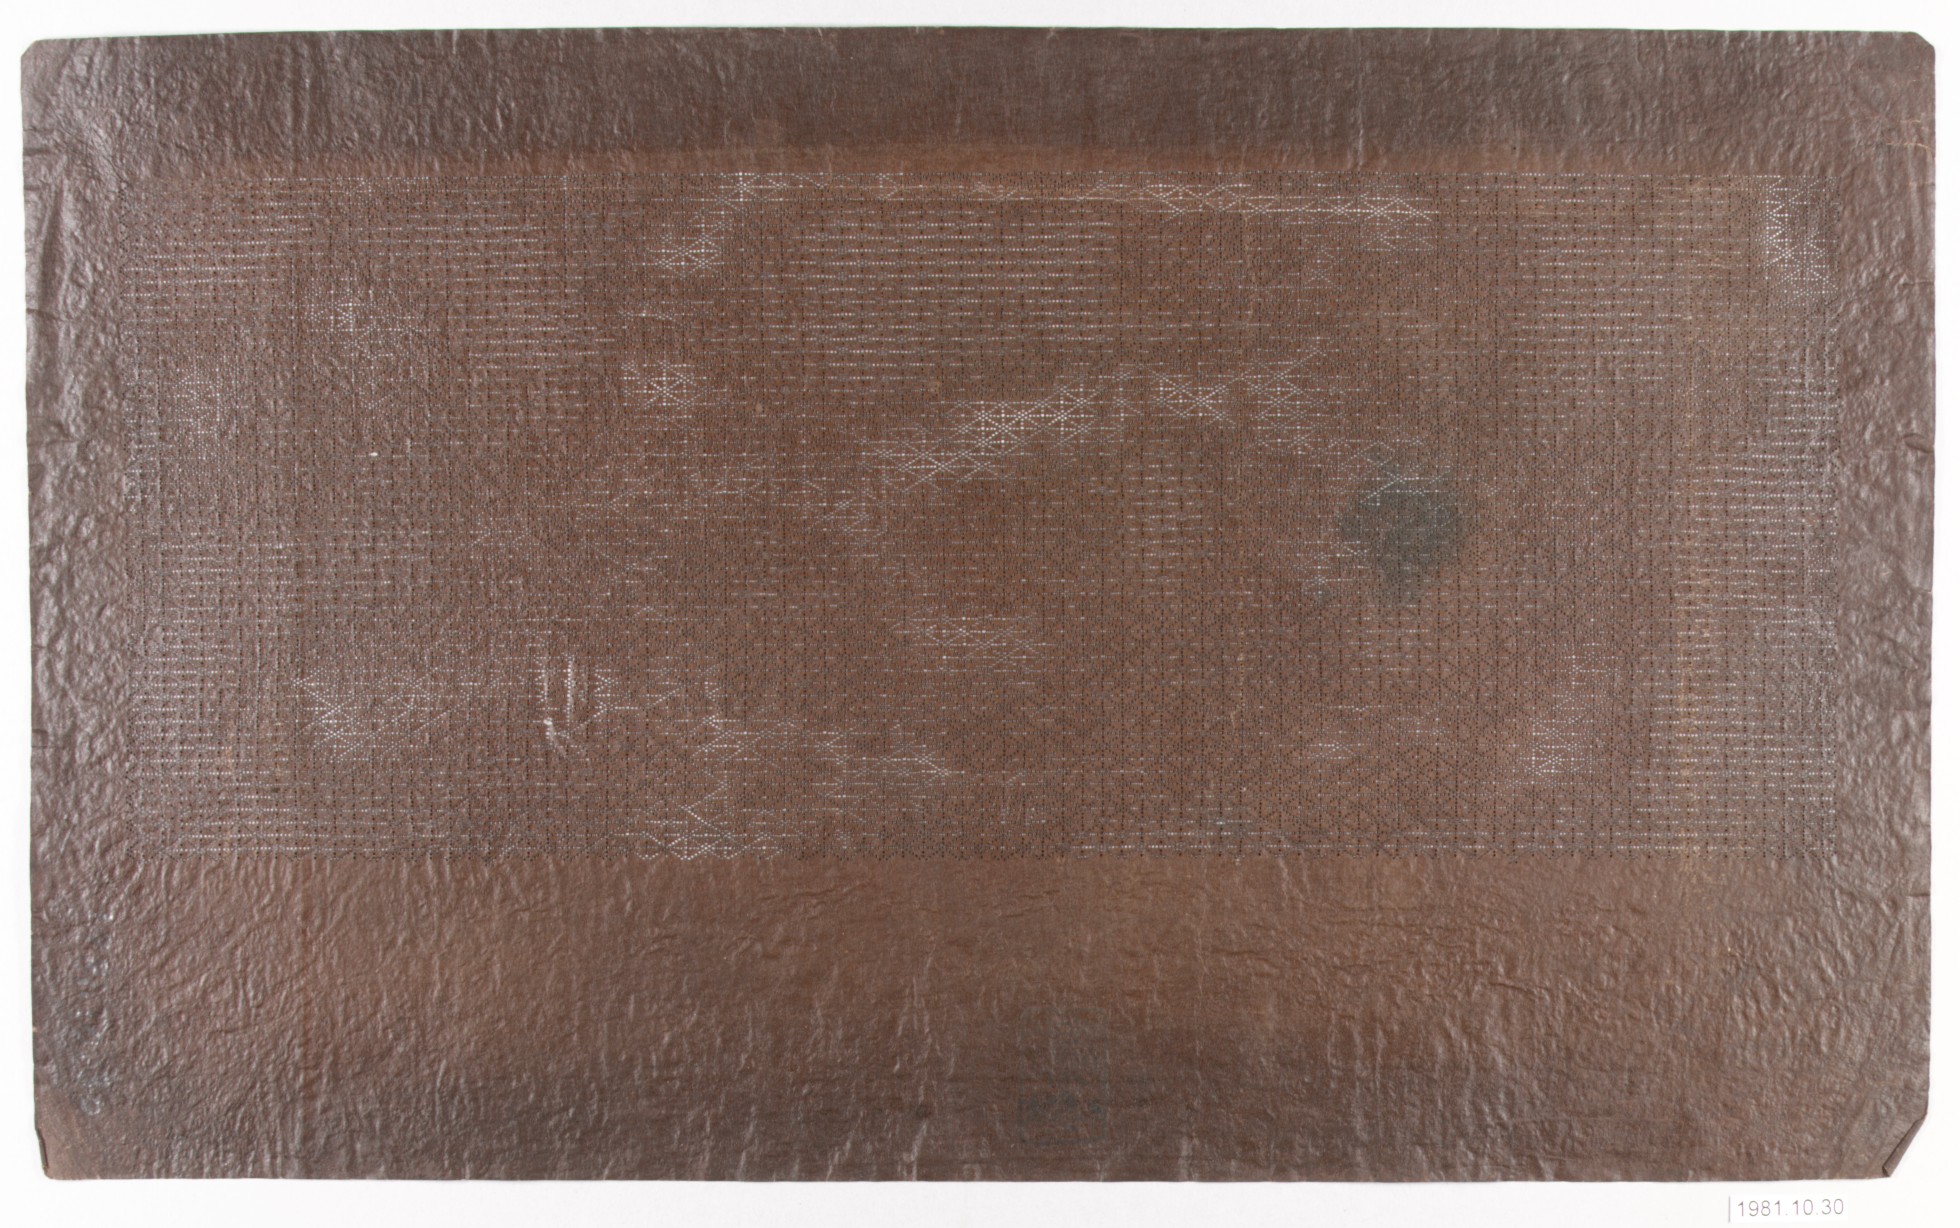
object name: stencil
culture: japanese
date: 1801-1900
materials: paper